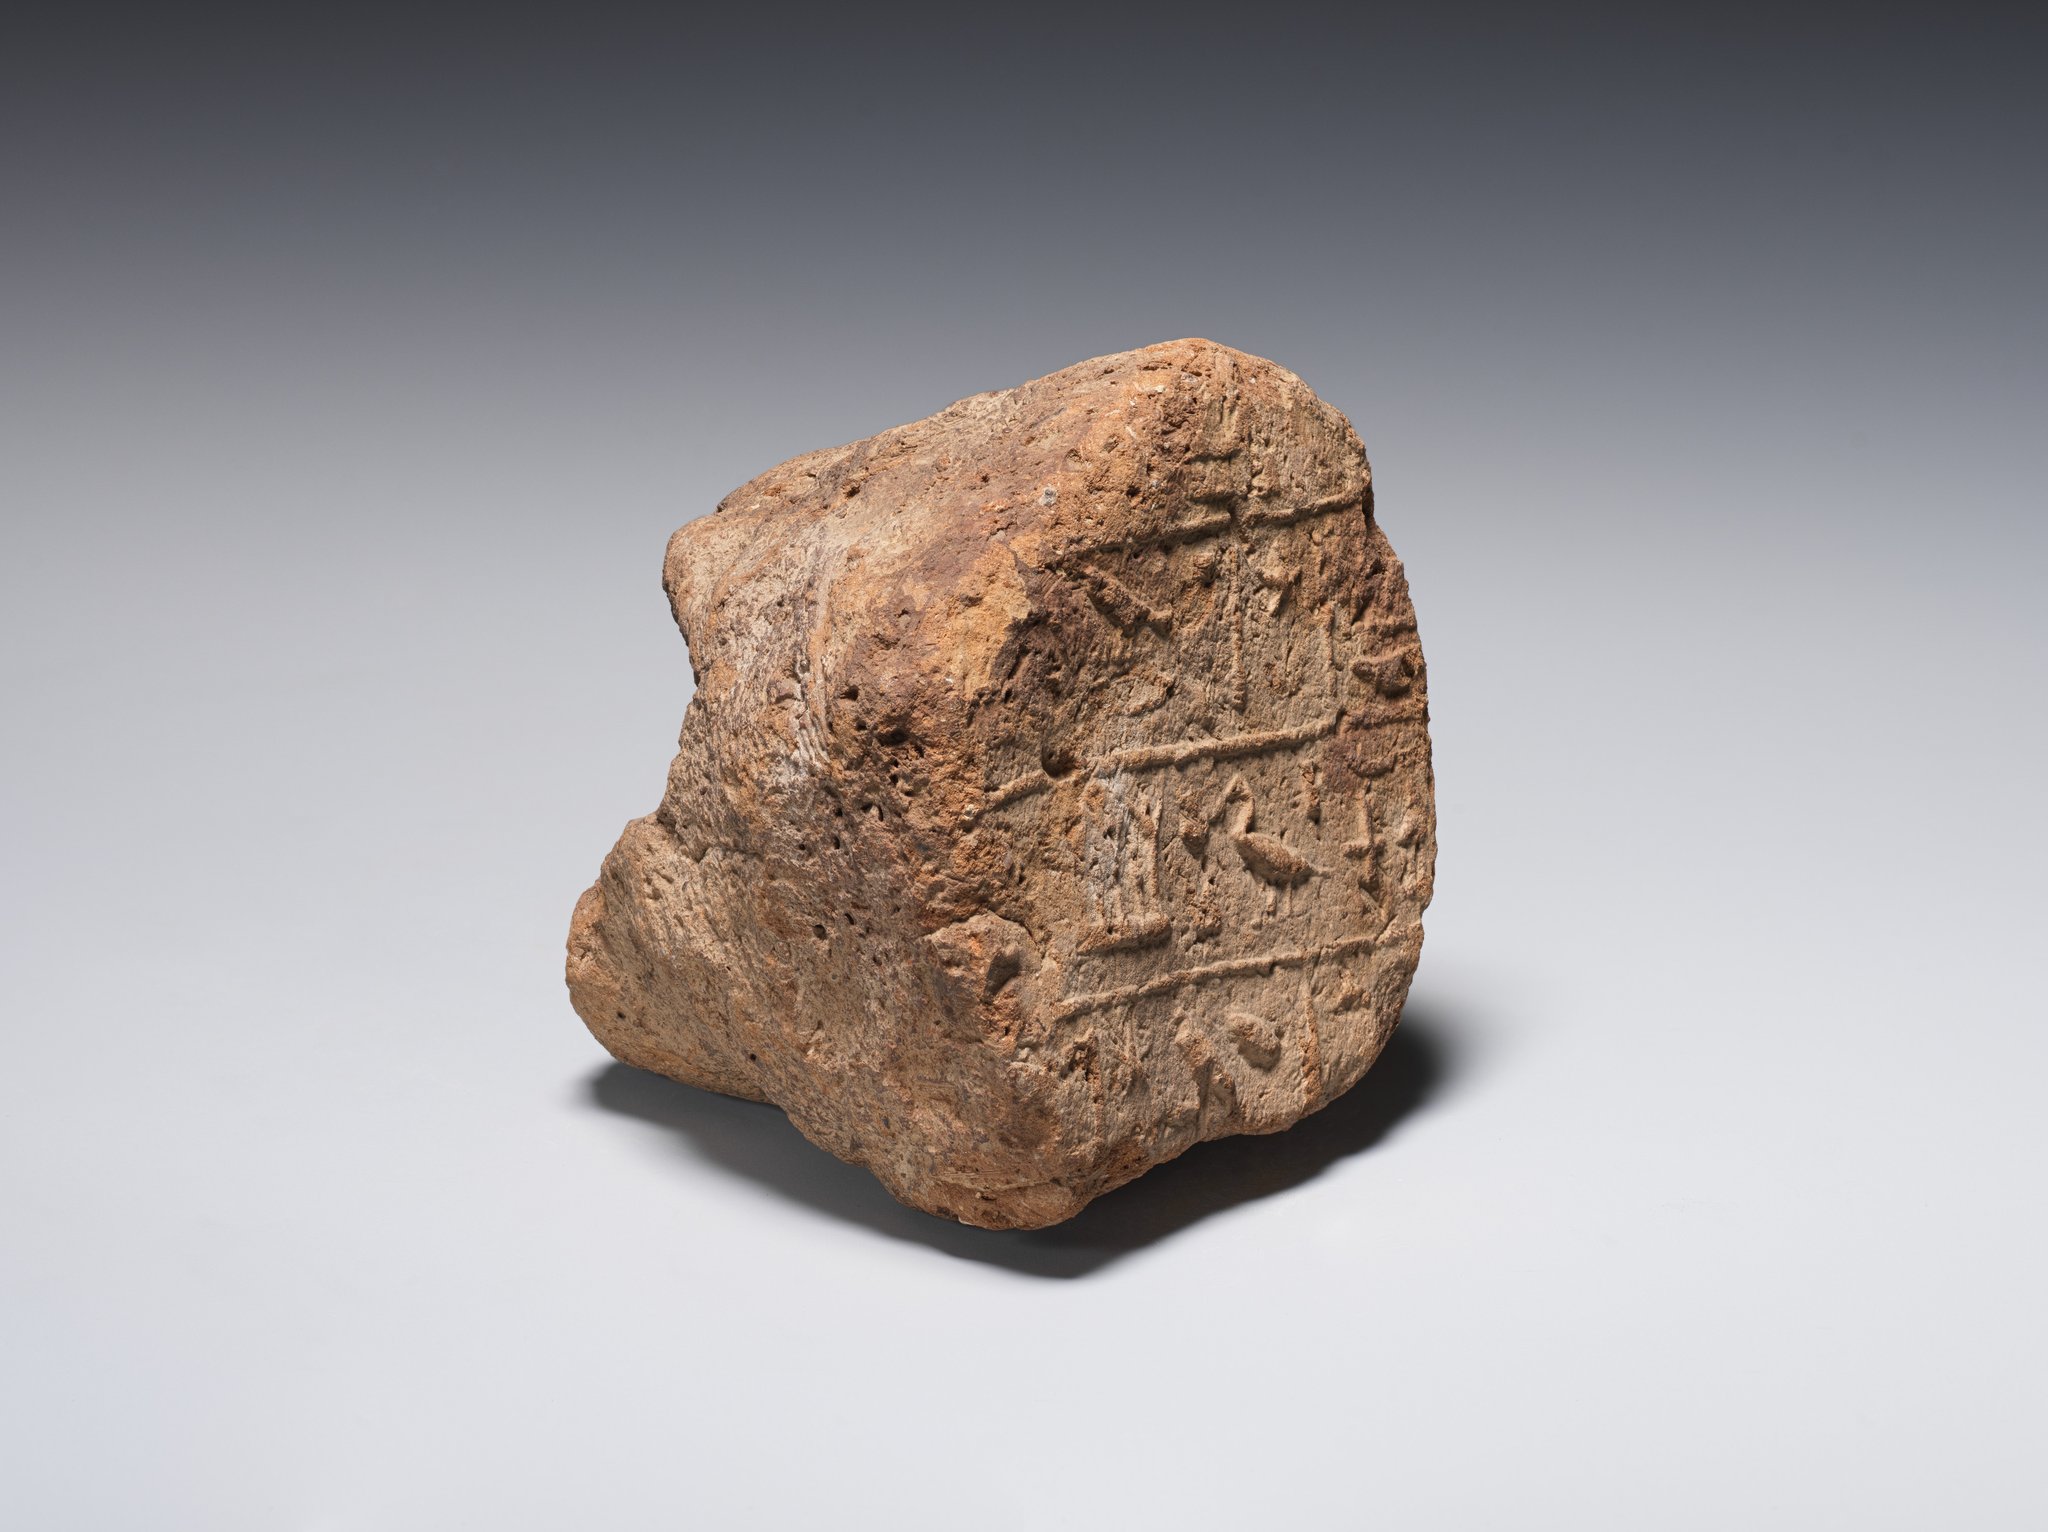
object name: cone, sheshonq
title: Funerary Cone of Sheshonq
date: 570-526 BCE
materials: pottery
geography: egypt